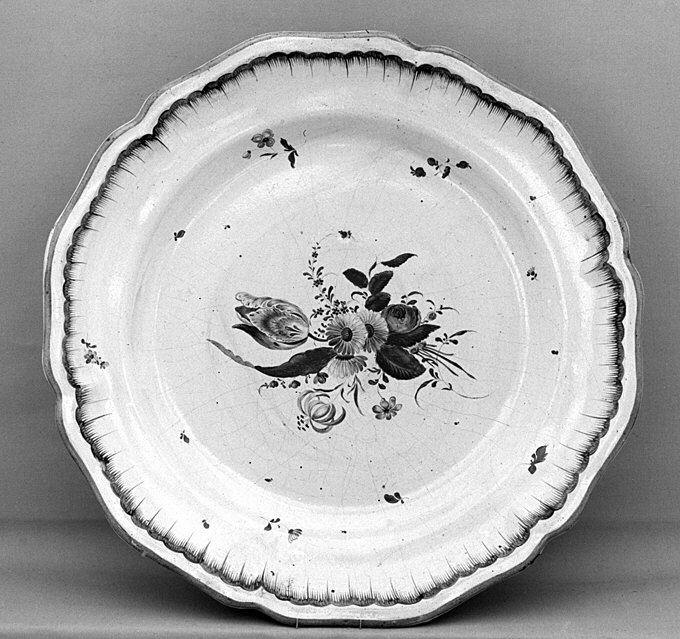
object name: plaque or plate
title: Plate or plaque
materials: faience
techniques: glazing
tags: flowers